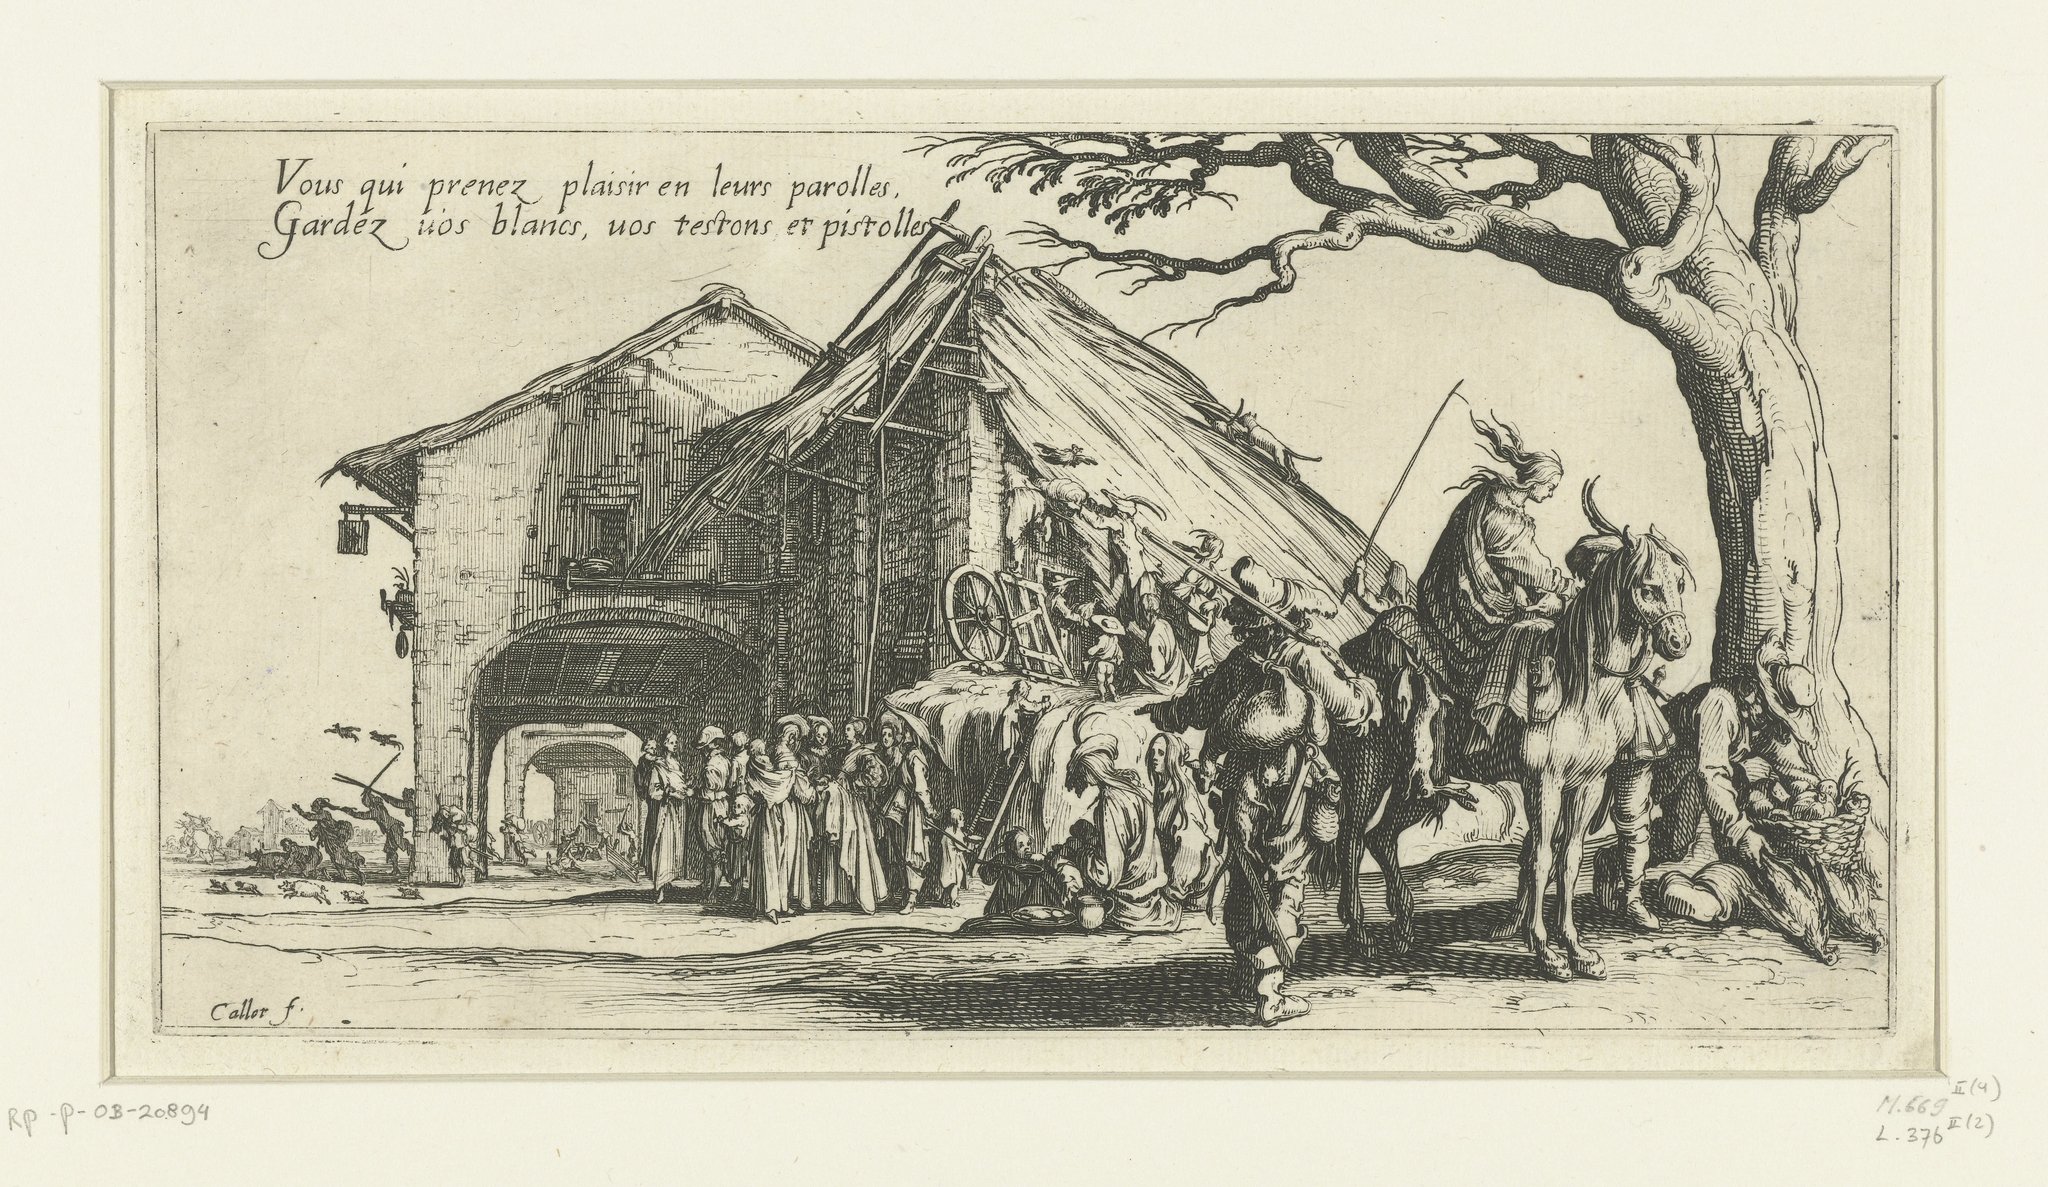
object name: print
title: Zigeuners bij een herberg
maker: jacques callot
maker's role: draughtsman, print maker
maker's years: 1592-1635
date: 1621-1631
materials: paper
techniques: engraving, etching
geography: nancy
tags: wandering communities: romani or roma, theft, hotel, hostelry, inn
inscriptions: collector's mark: Lugt 240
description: Bij een herberg leest een aantal zigeunervrouwen een voorname heer en dame de hand, terwijl hun reisgenoten voedsel en goederen stelen. Bovenin de voorstelling twee regels Franse tekst. Deze prent is onderdeel van een serie van vier prenten met voorstellingen van het leven van zigeuners.